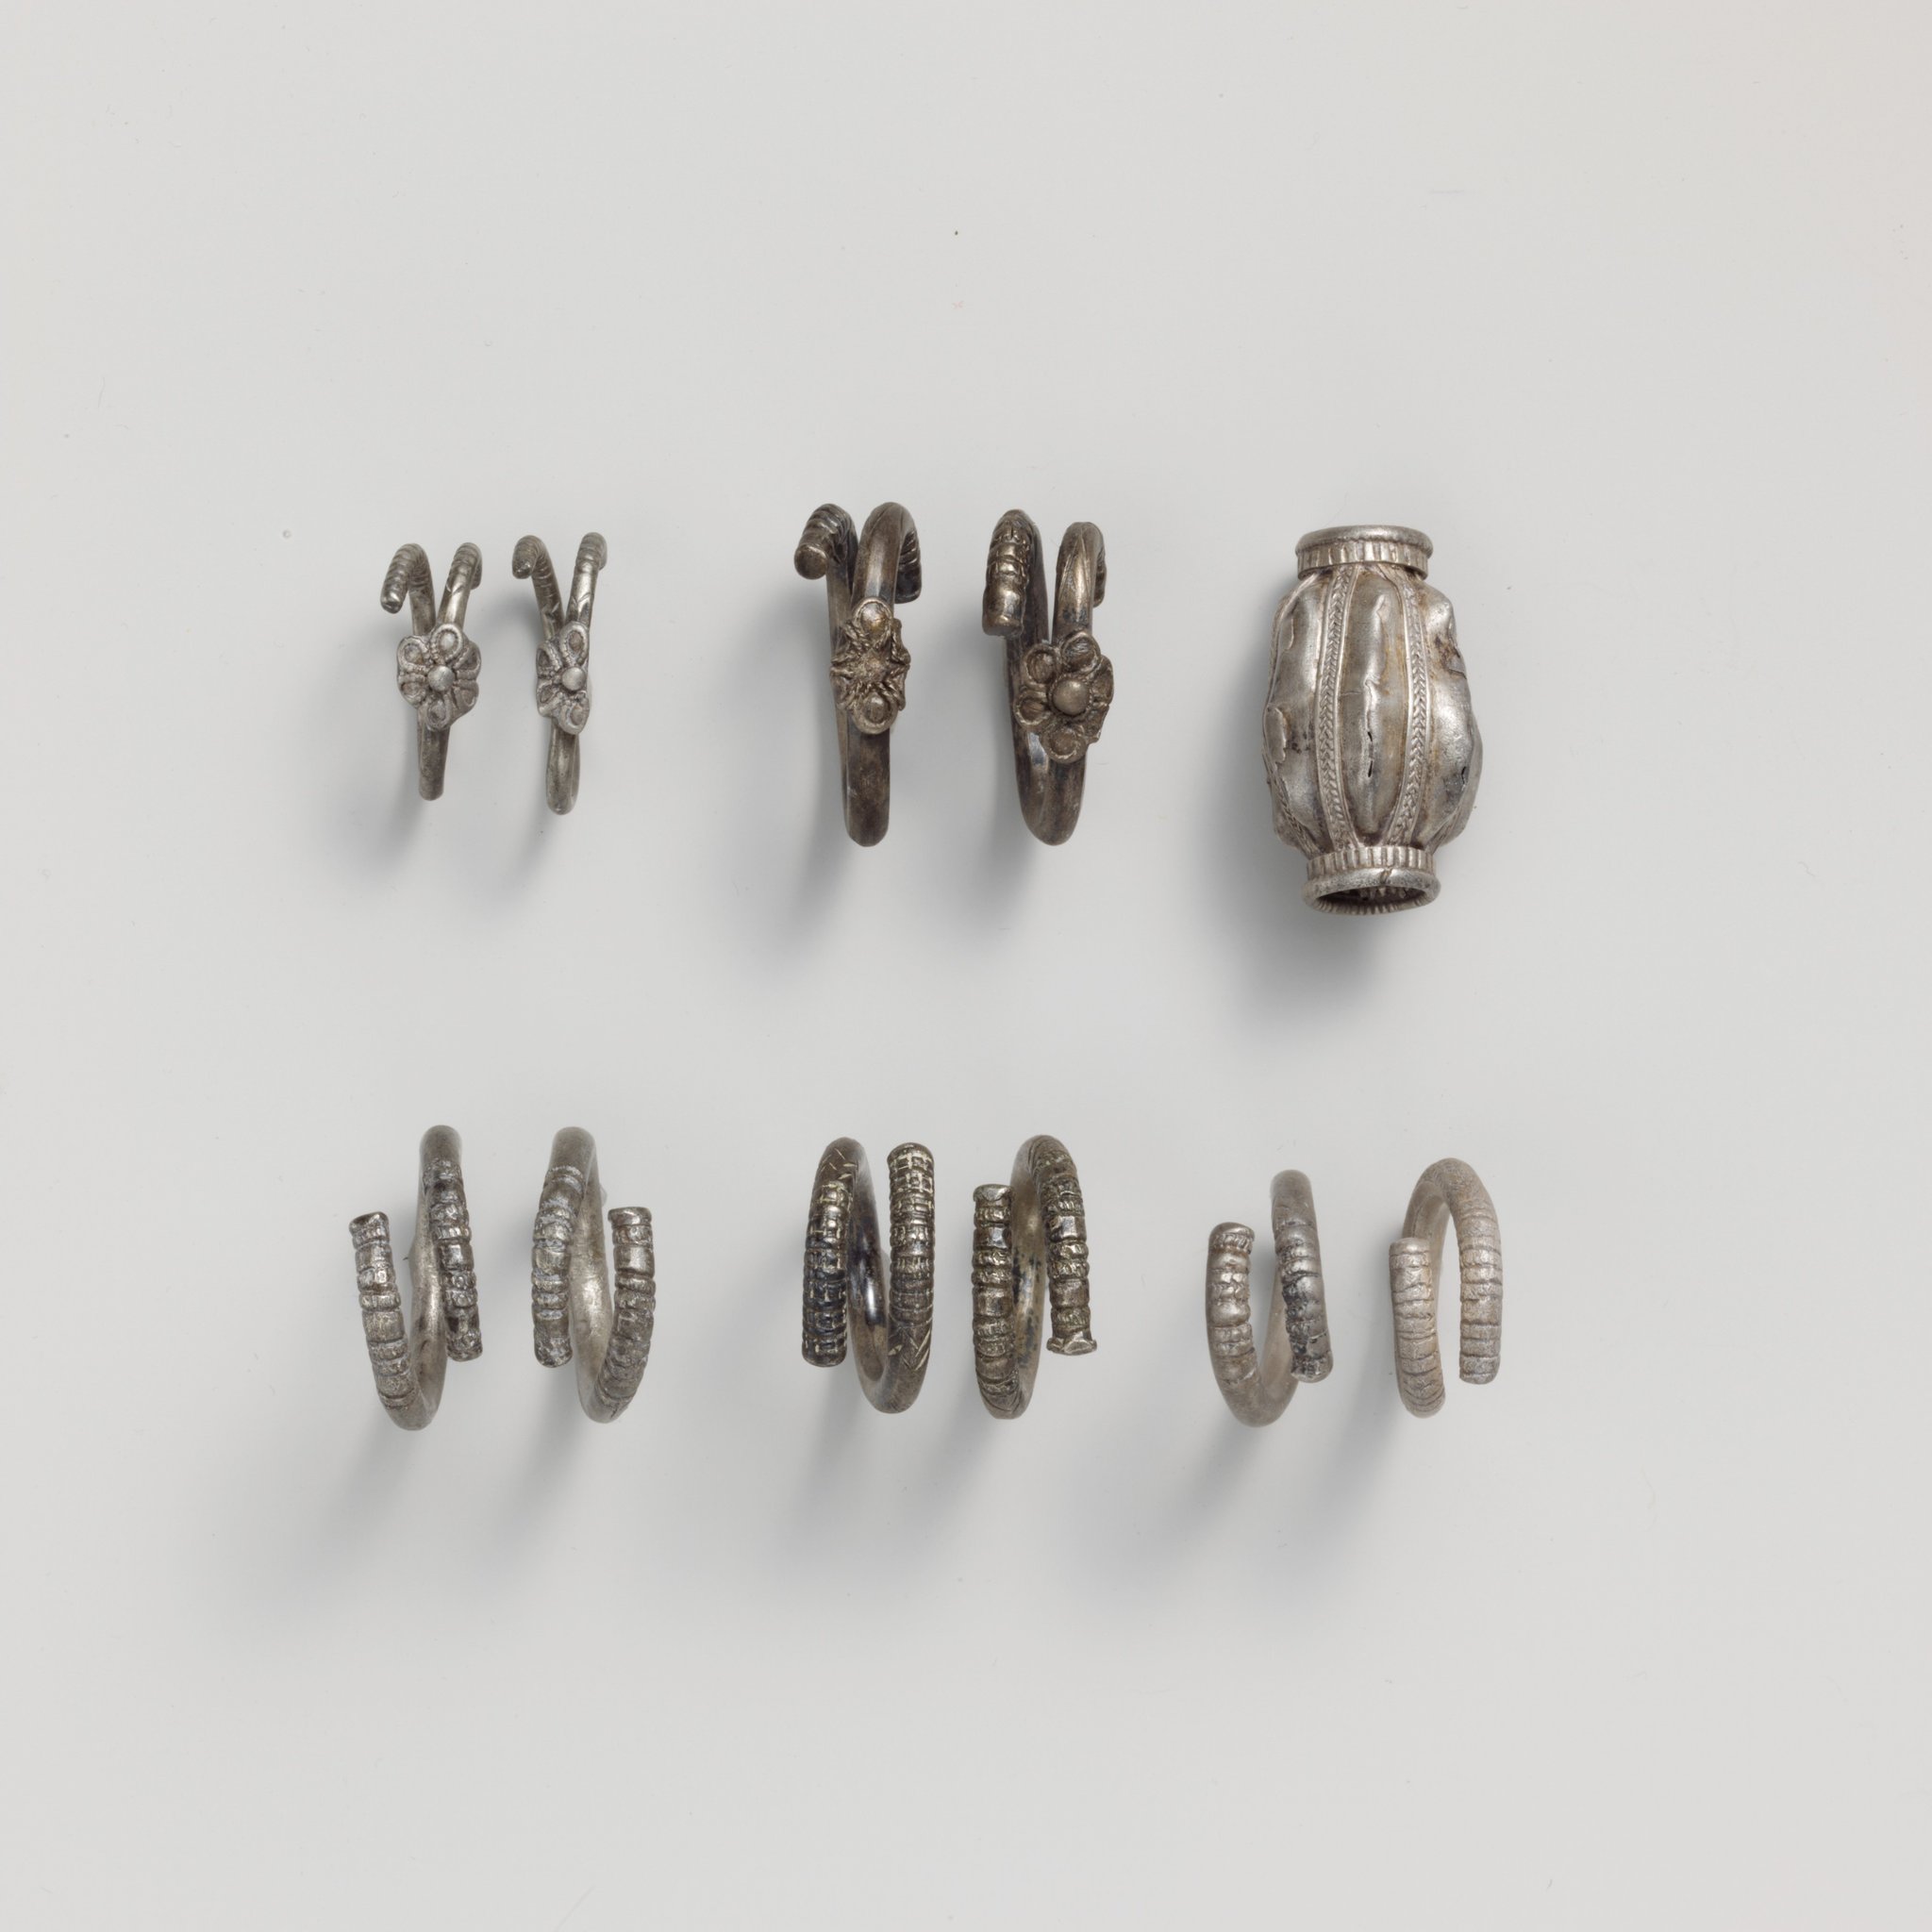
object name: bead, spiral, ornament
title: Silver gilt spirals and bead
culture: greek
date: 550-501 BCE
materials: gold, silver